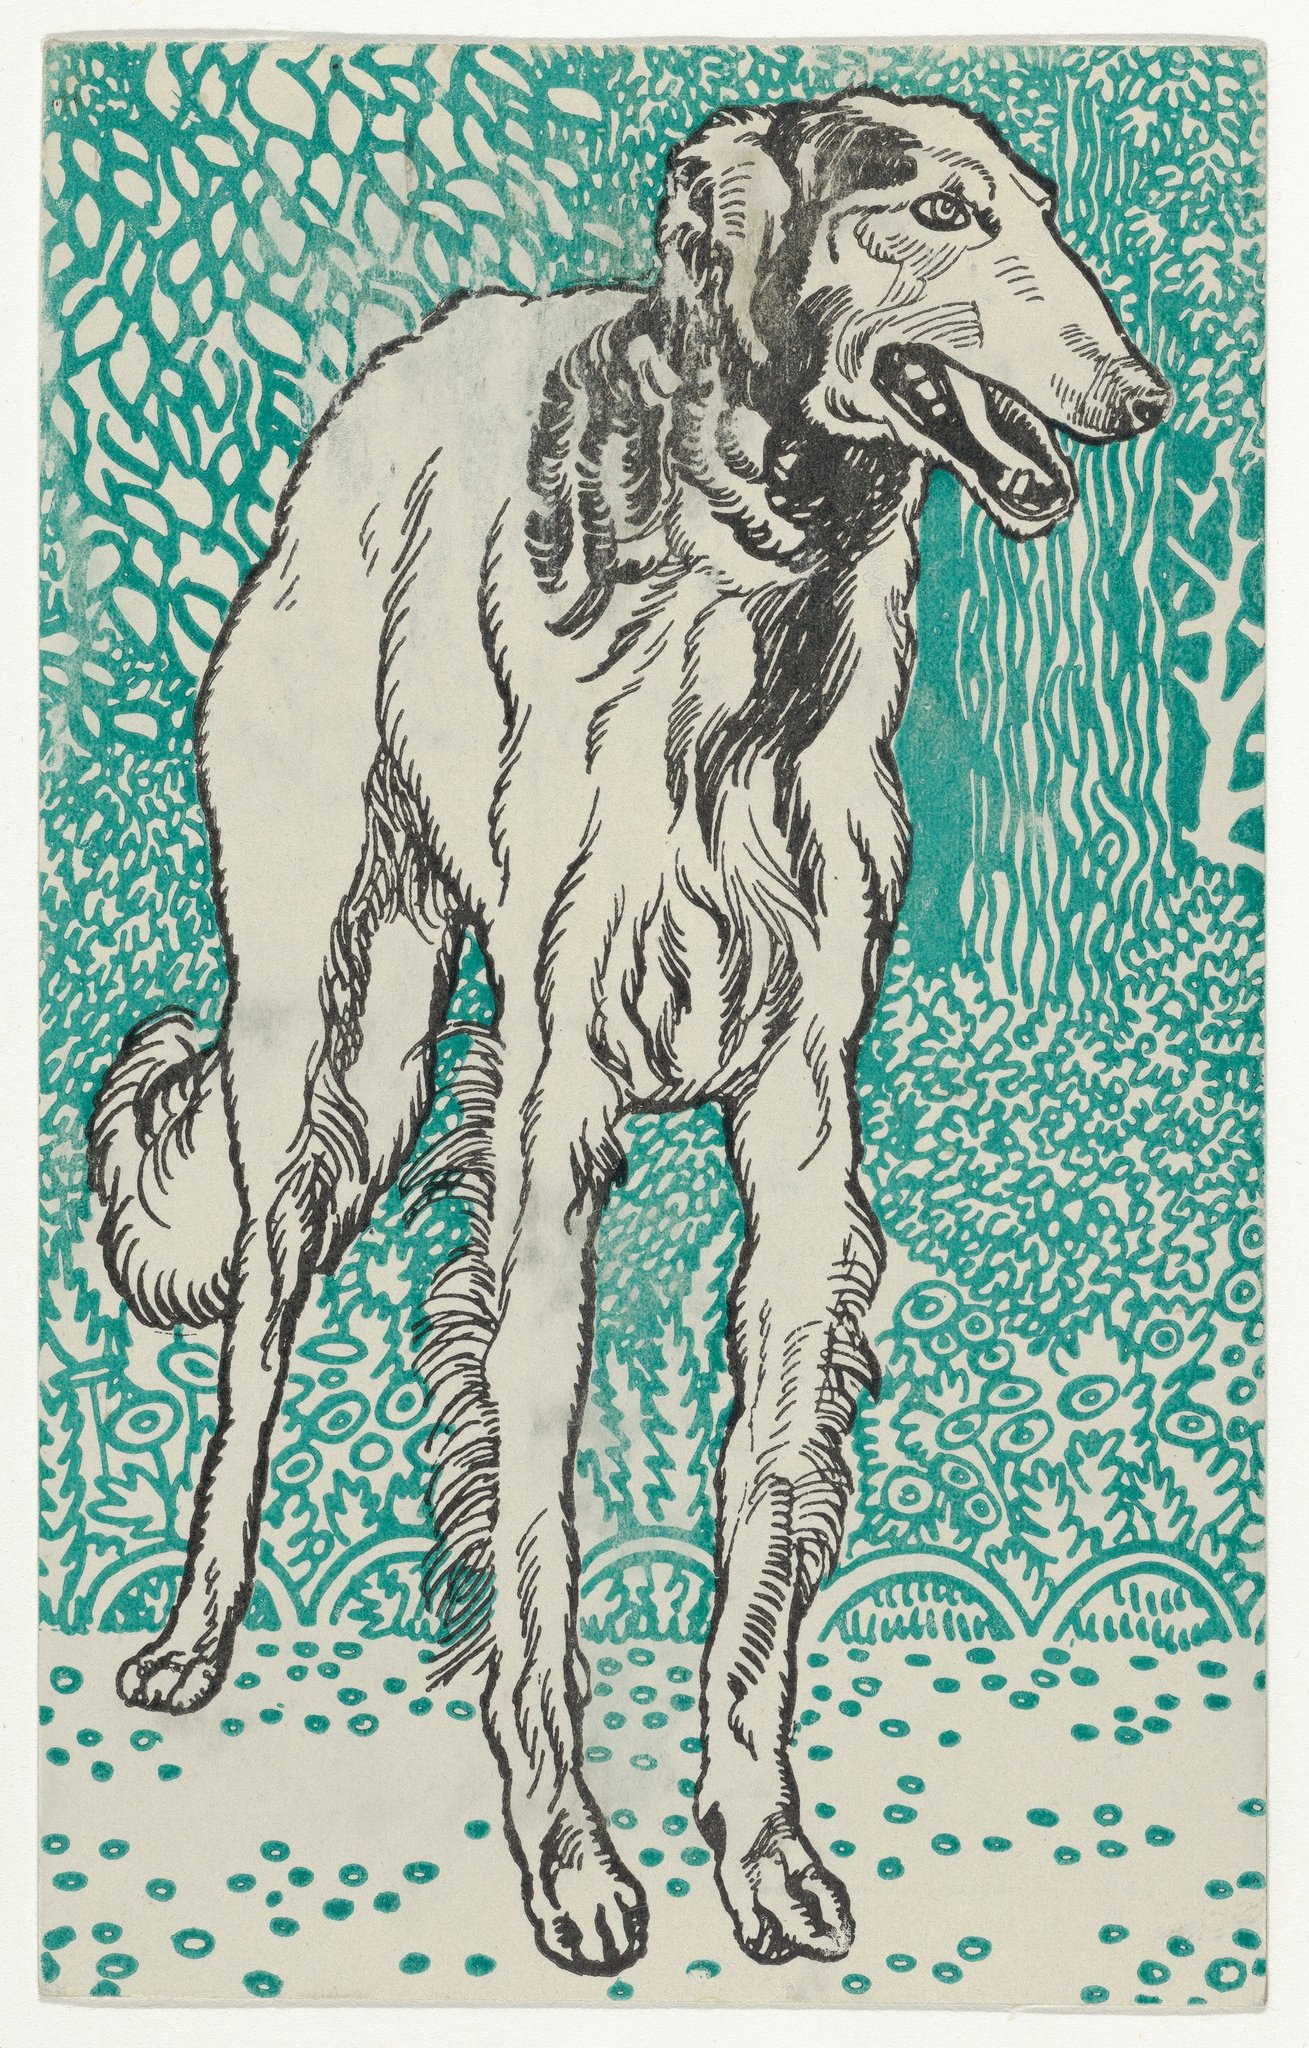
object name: print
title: Greyhound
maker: moriz jung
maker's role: artist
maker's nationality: austrian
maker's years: 1885-1915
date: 1912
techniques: lithograph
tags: dogs